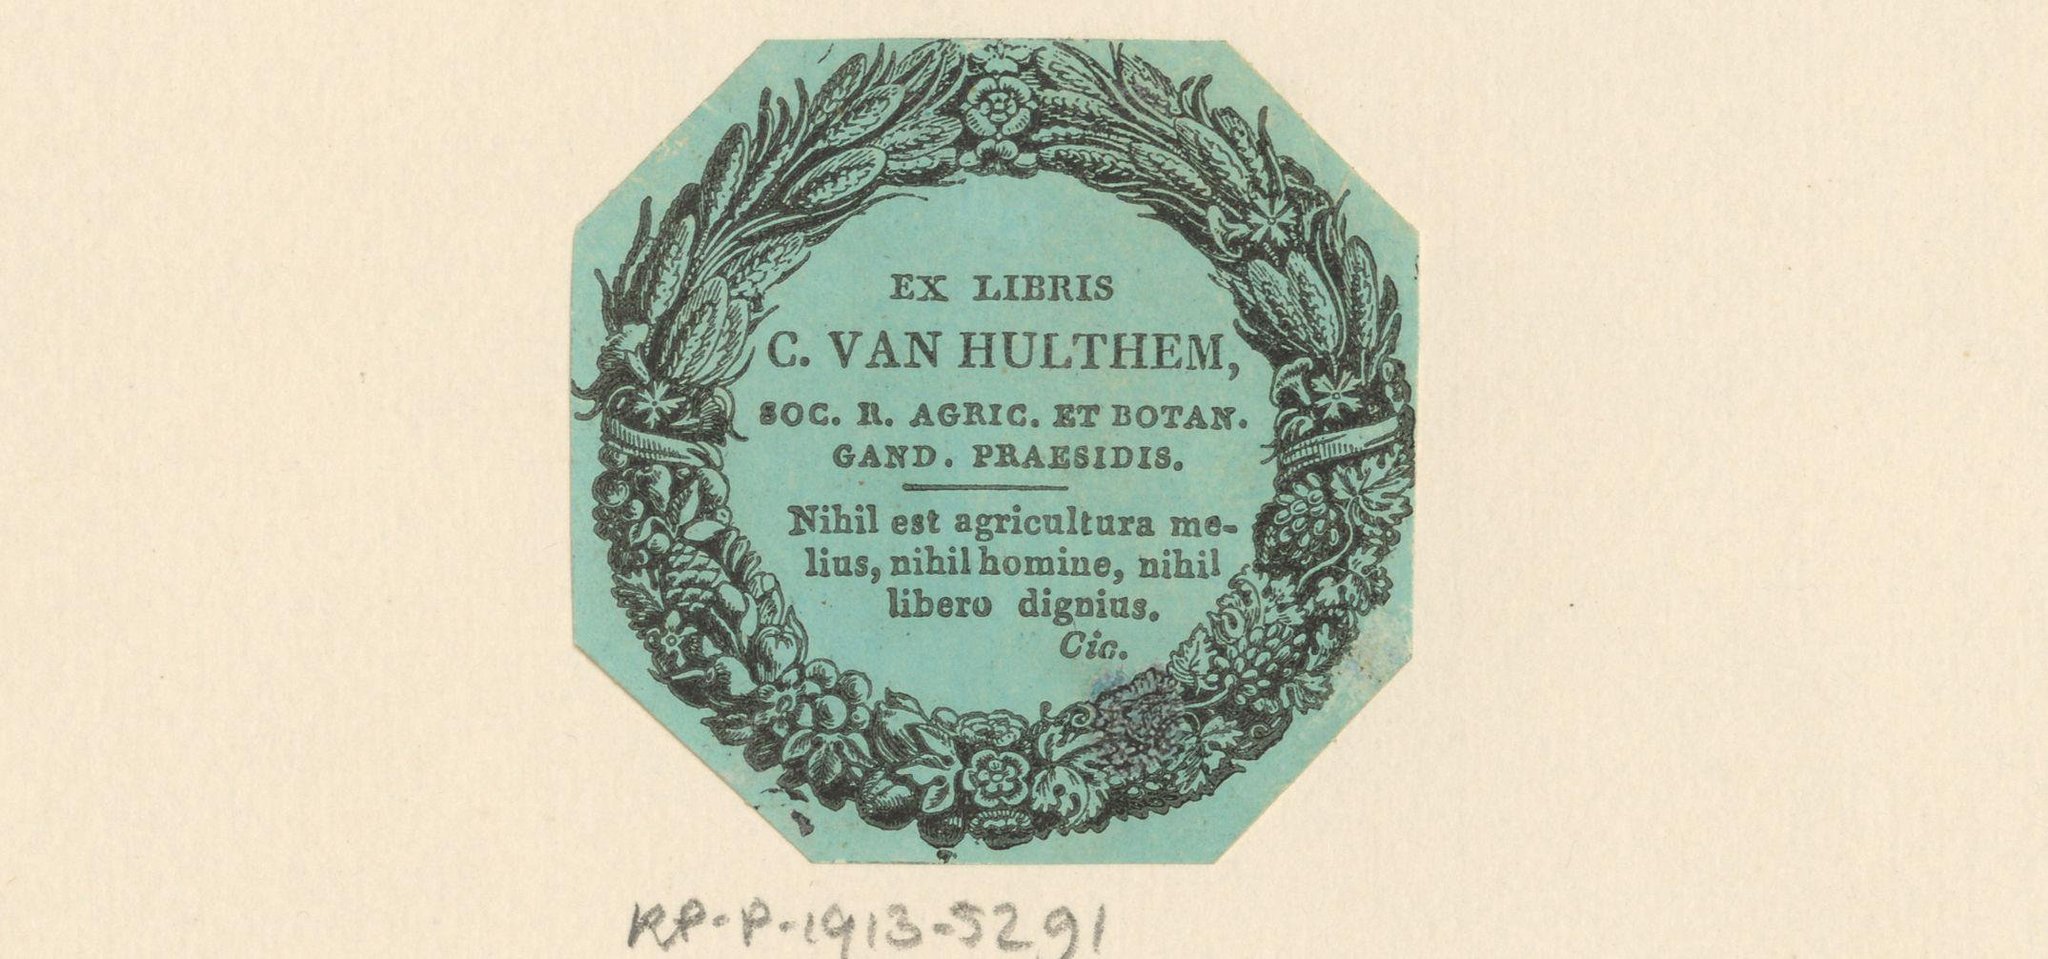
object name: bookplate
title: Ex libris van Charles Van Hulthem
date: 1774-1832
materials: paper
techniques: letterpress printing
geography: belgium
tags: ghent, politician, garland, wreath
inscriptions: collector's mark: Lugt 2760, collector's mark: Lugt 2233